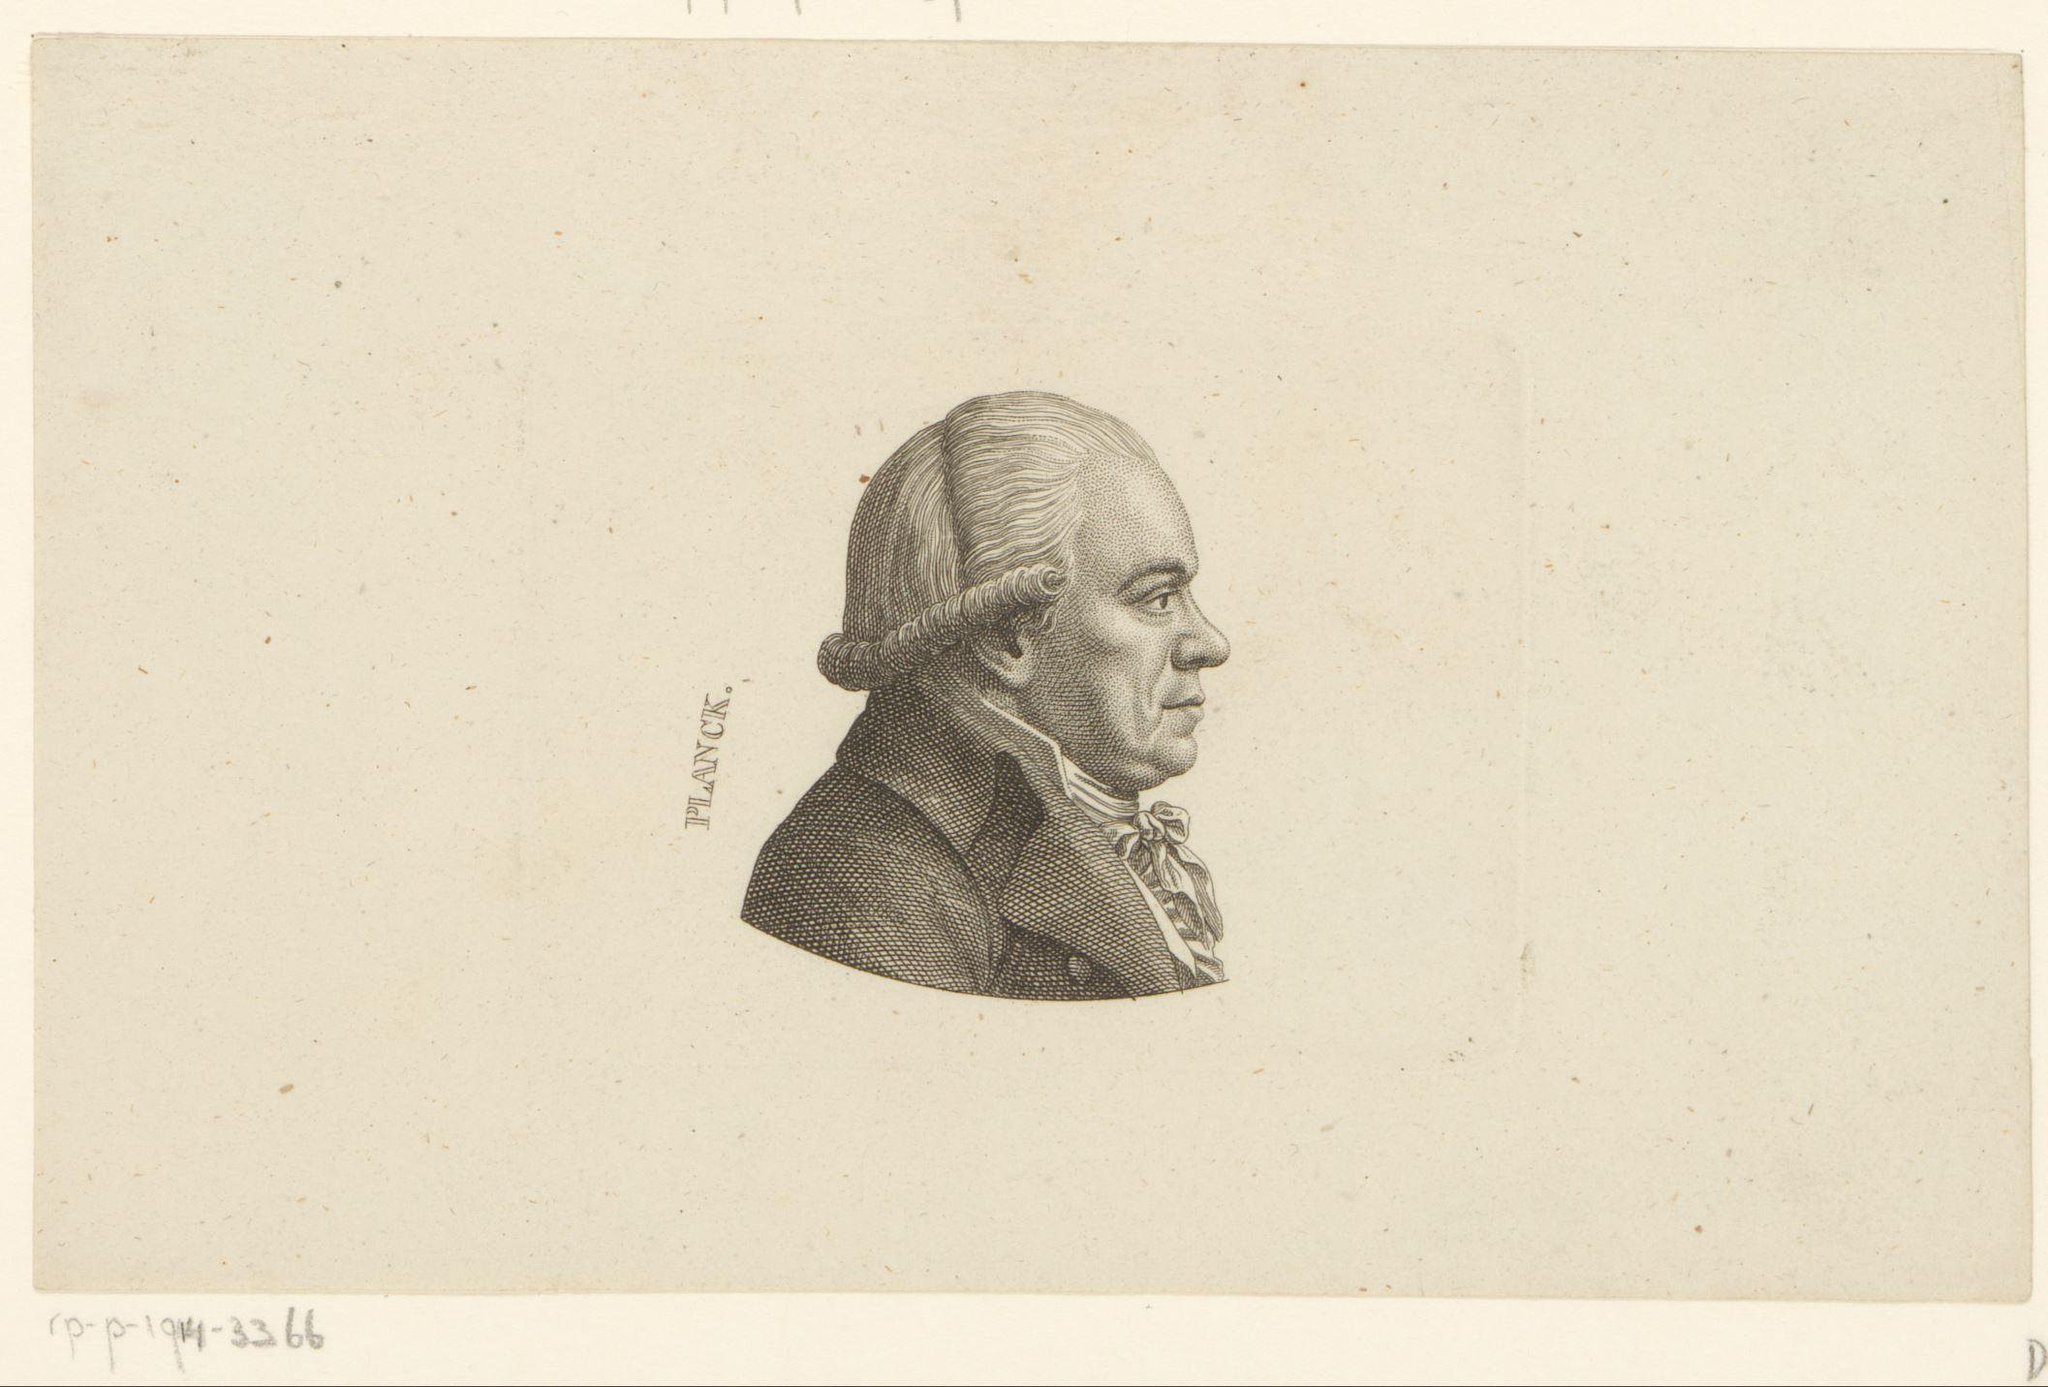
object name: print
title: Portret van Gottlieb Jakob Planck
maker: ernst ludwig riepenhausen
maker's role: print maker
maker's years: 1765-1840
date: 1775-1840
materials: paper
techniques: engraving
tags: theologian, historical persons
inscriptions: collector's mark: Lugt 2228